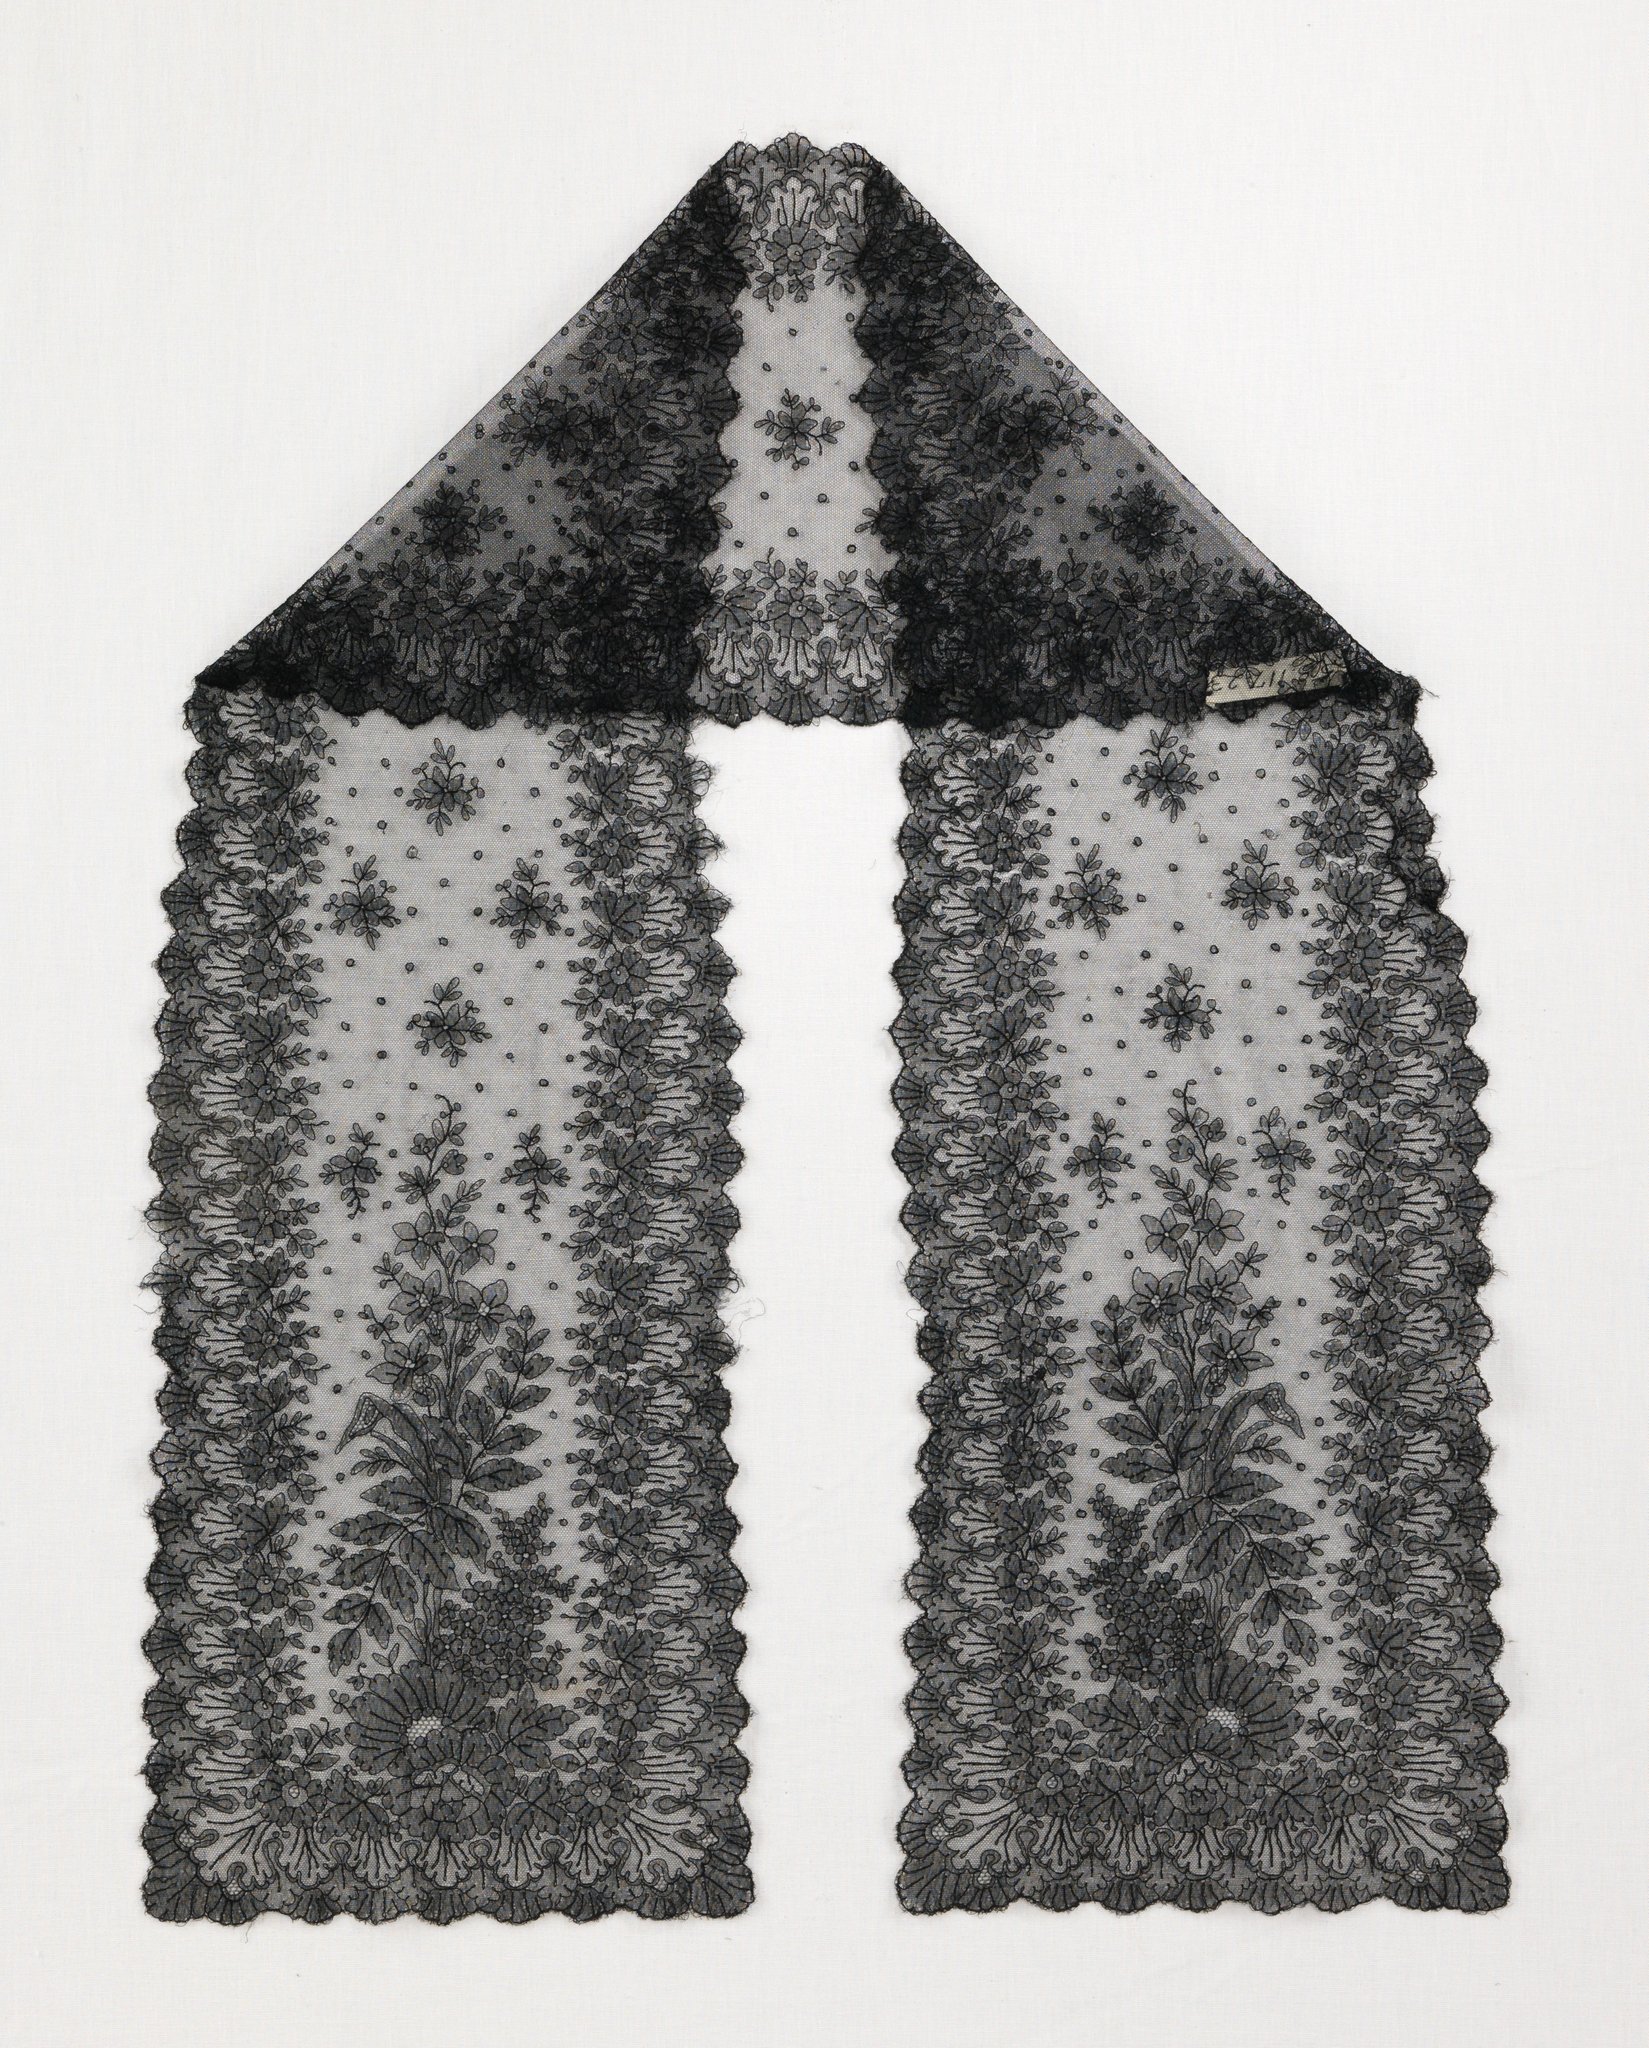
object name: scarf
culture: french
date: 1870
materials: silk